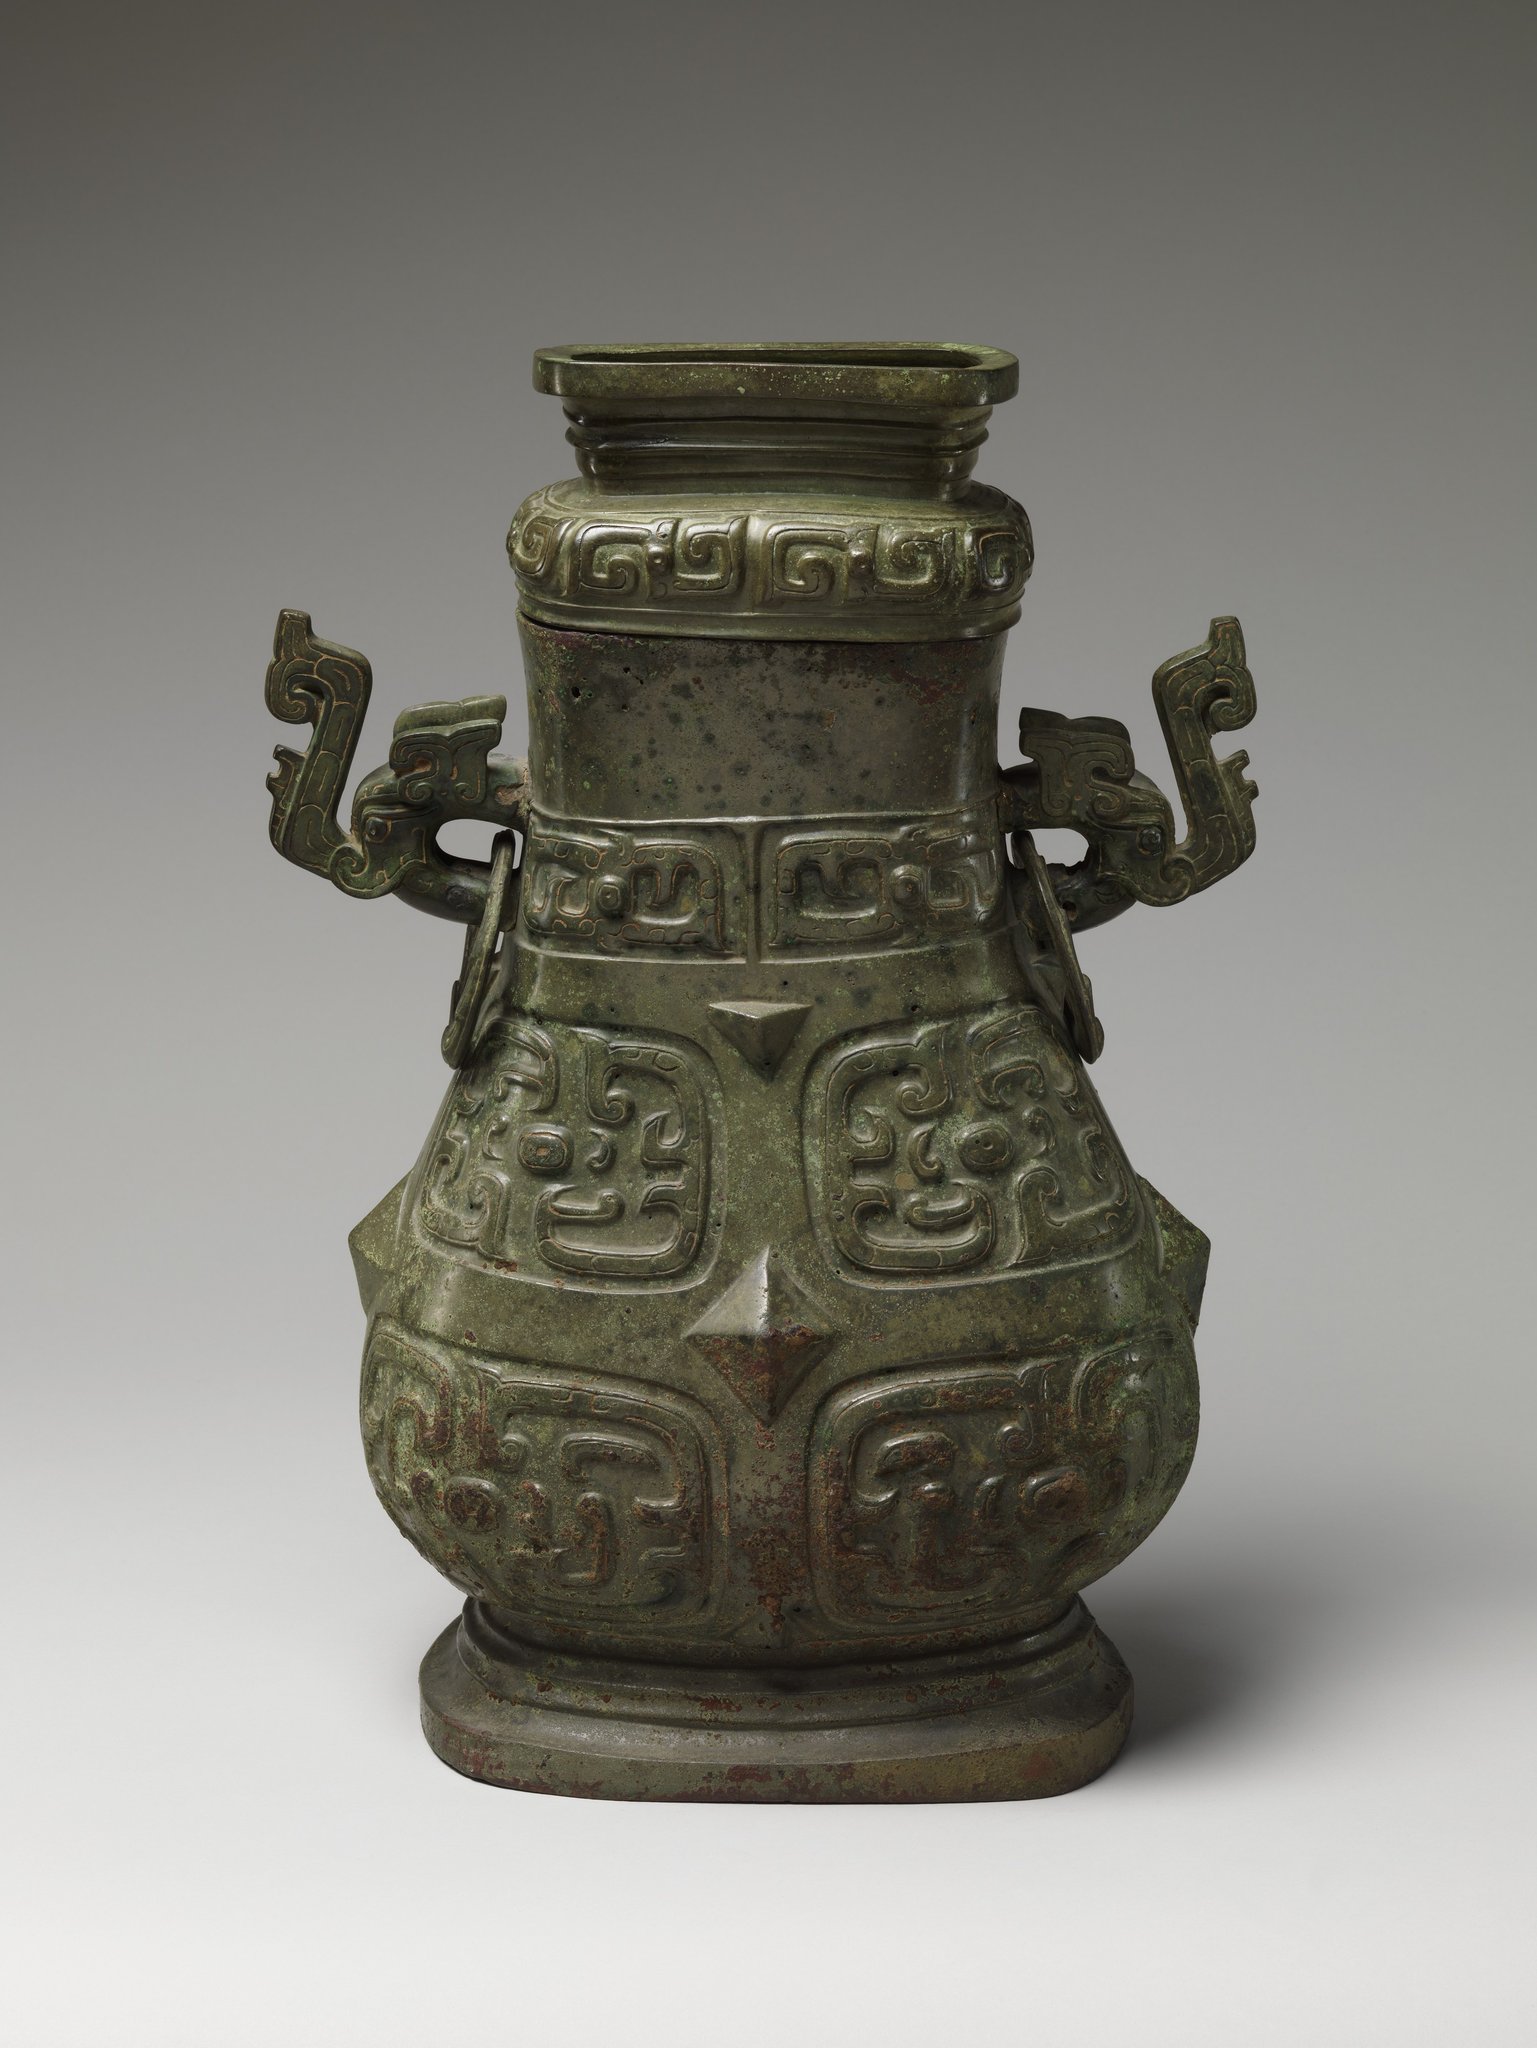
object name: wine vessel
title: Wine container (Hu)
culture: chinese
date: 834-768 BCE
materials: bronze